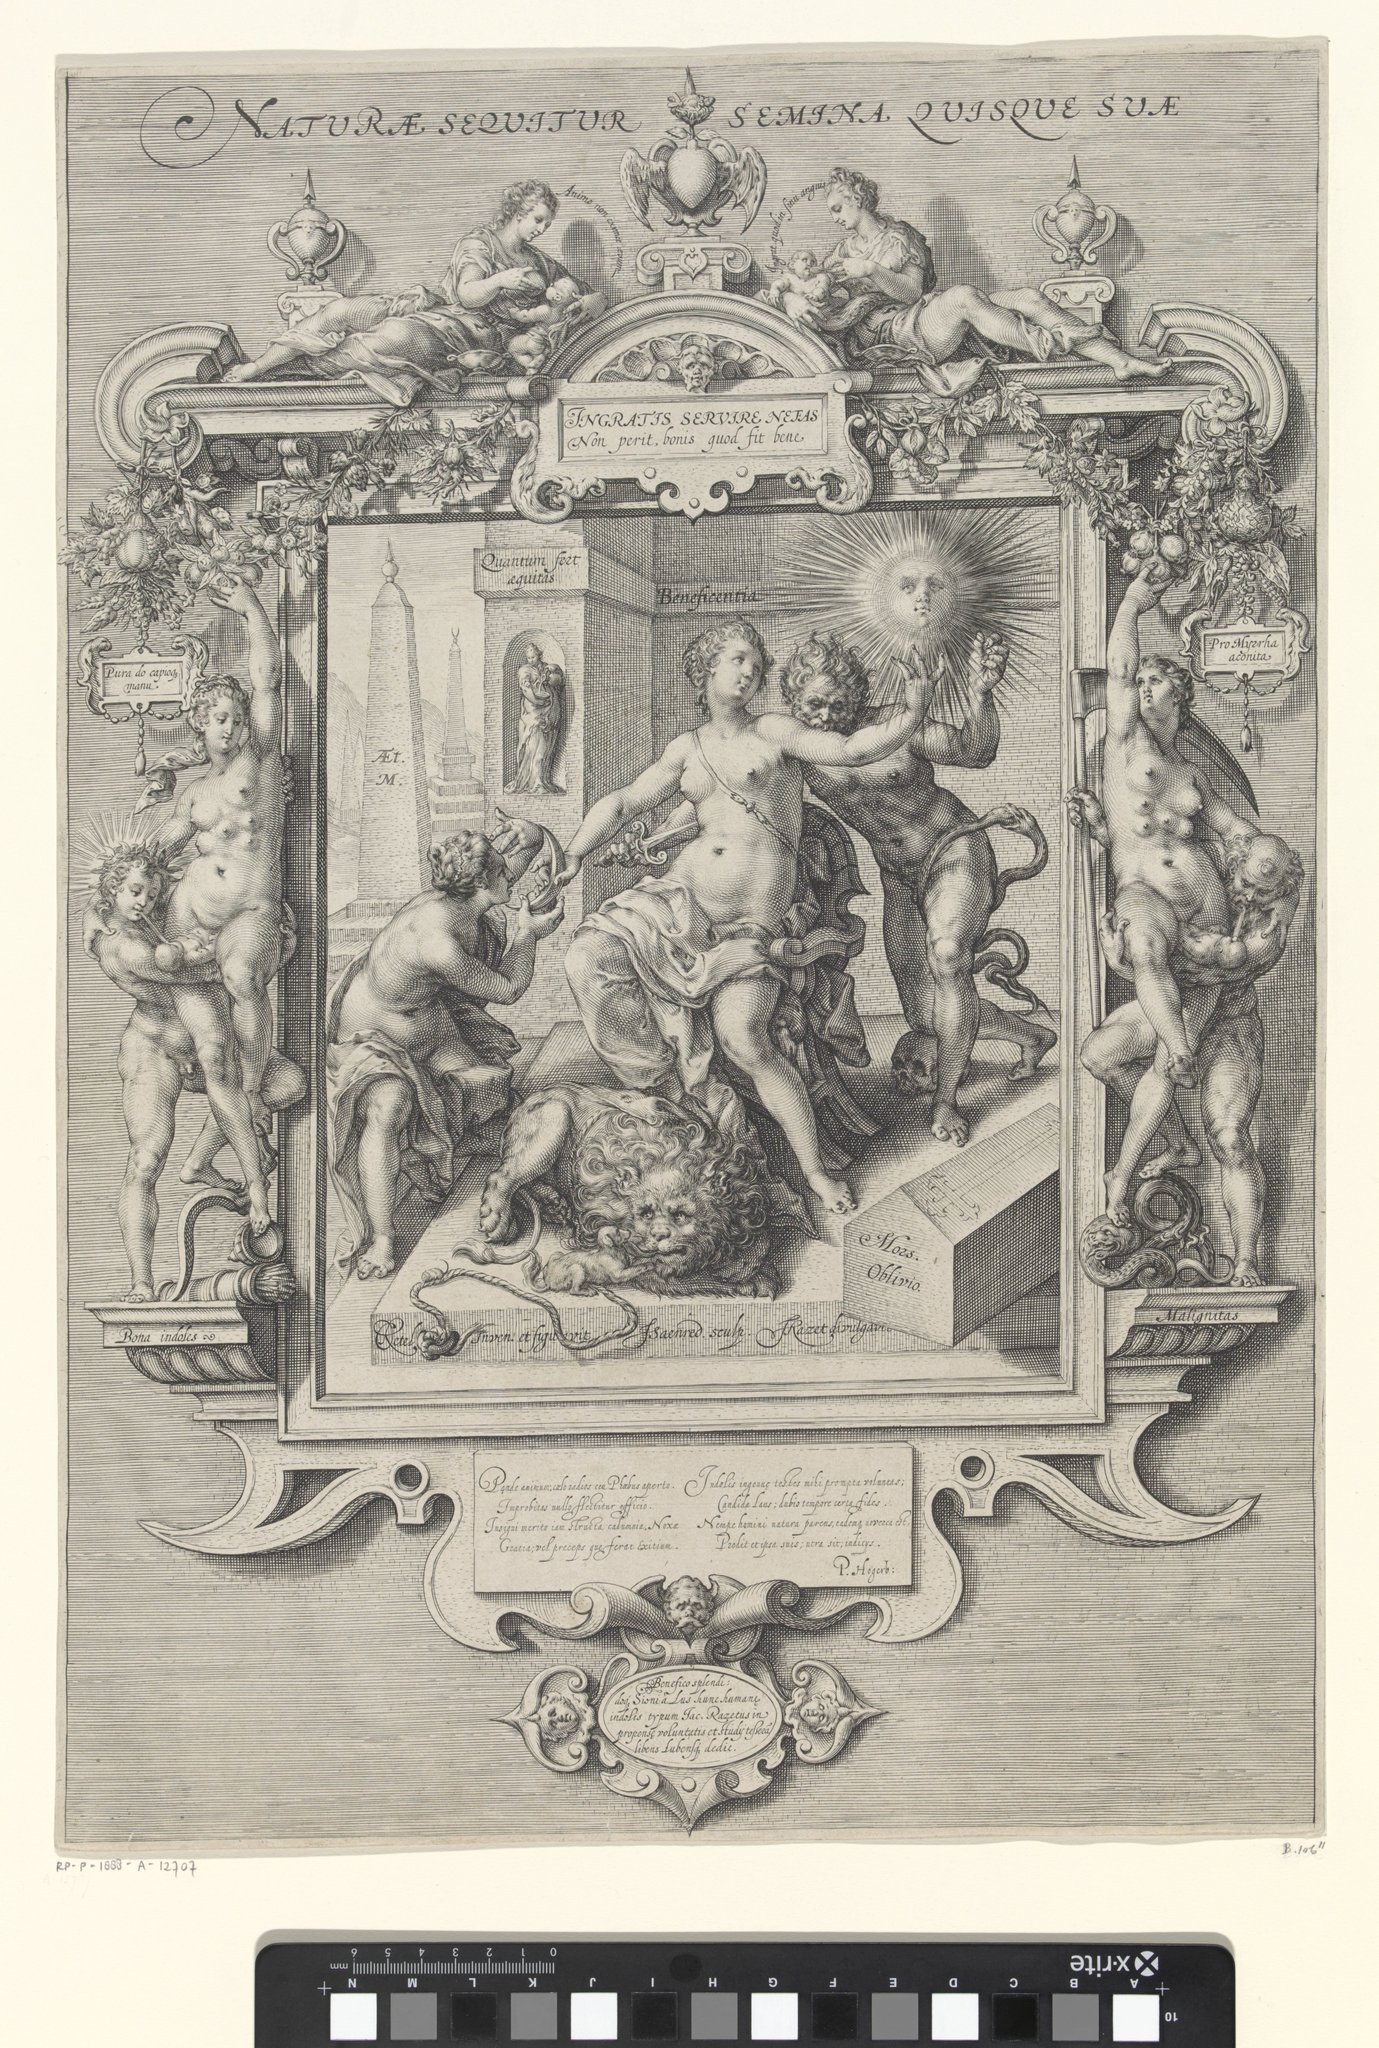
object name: print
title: Allegorie op de menselijke aard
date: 1610-1648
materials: paper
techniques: engraving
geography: northern netherlands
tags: fertility, good, right, bad, evil, wrong, (story of) apollo (phoebus), nursing, suckling, sun as celestial body, beasts of prey, predatory animals: lion, moon as celestial body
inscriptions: collector's mark: Lugt 2228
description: Beneficentia, de personificatie van weldadigheid, zit op een stoel en wordt van achteren neergestoken door het kwaad in de gedaante van een naakte man. Een knie van de man leunt op een schedel en een slang, die in zijn eigen staart bijt als symbool van eeuwigheid, hangt rond zijn rechterbeen. Rechts staat een doodskist met het opschrift: Mors Oblivio. Met haar linkerhand geeft Beneficentia de zon aan de naakte man. De maan geeft ze aan de vrouw voor haar. Tussen hen in ligt een vastgebonden leeuw, die aan een hond likt. Een muis knaagt aan zijn touw. Op de achtergrond enkele obelisken. De voorstelling heeft een ornamentele omlijsting. Links baart de personificatie van de vruchtbaarheid een kind, dat door de adem van Apollo als symbool van het goede tot leven wordt gewekt. Rechts wordt een kind gebaard dat zijn adem van het Kwaad ontvangt. Linksboven geeft een vrouw een kind de borst. Rechtsboven voedt een vrouw een kind met een lepel. Onder de voorstelling een achtregelige, Latijnse tekst en een cartouche met een vijfregelige, Latijnse tekst.